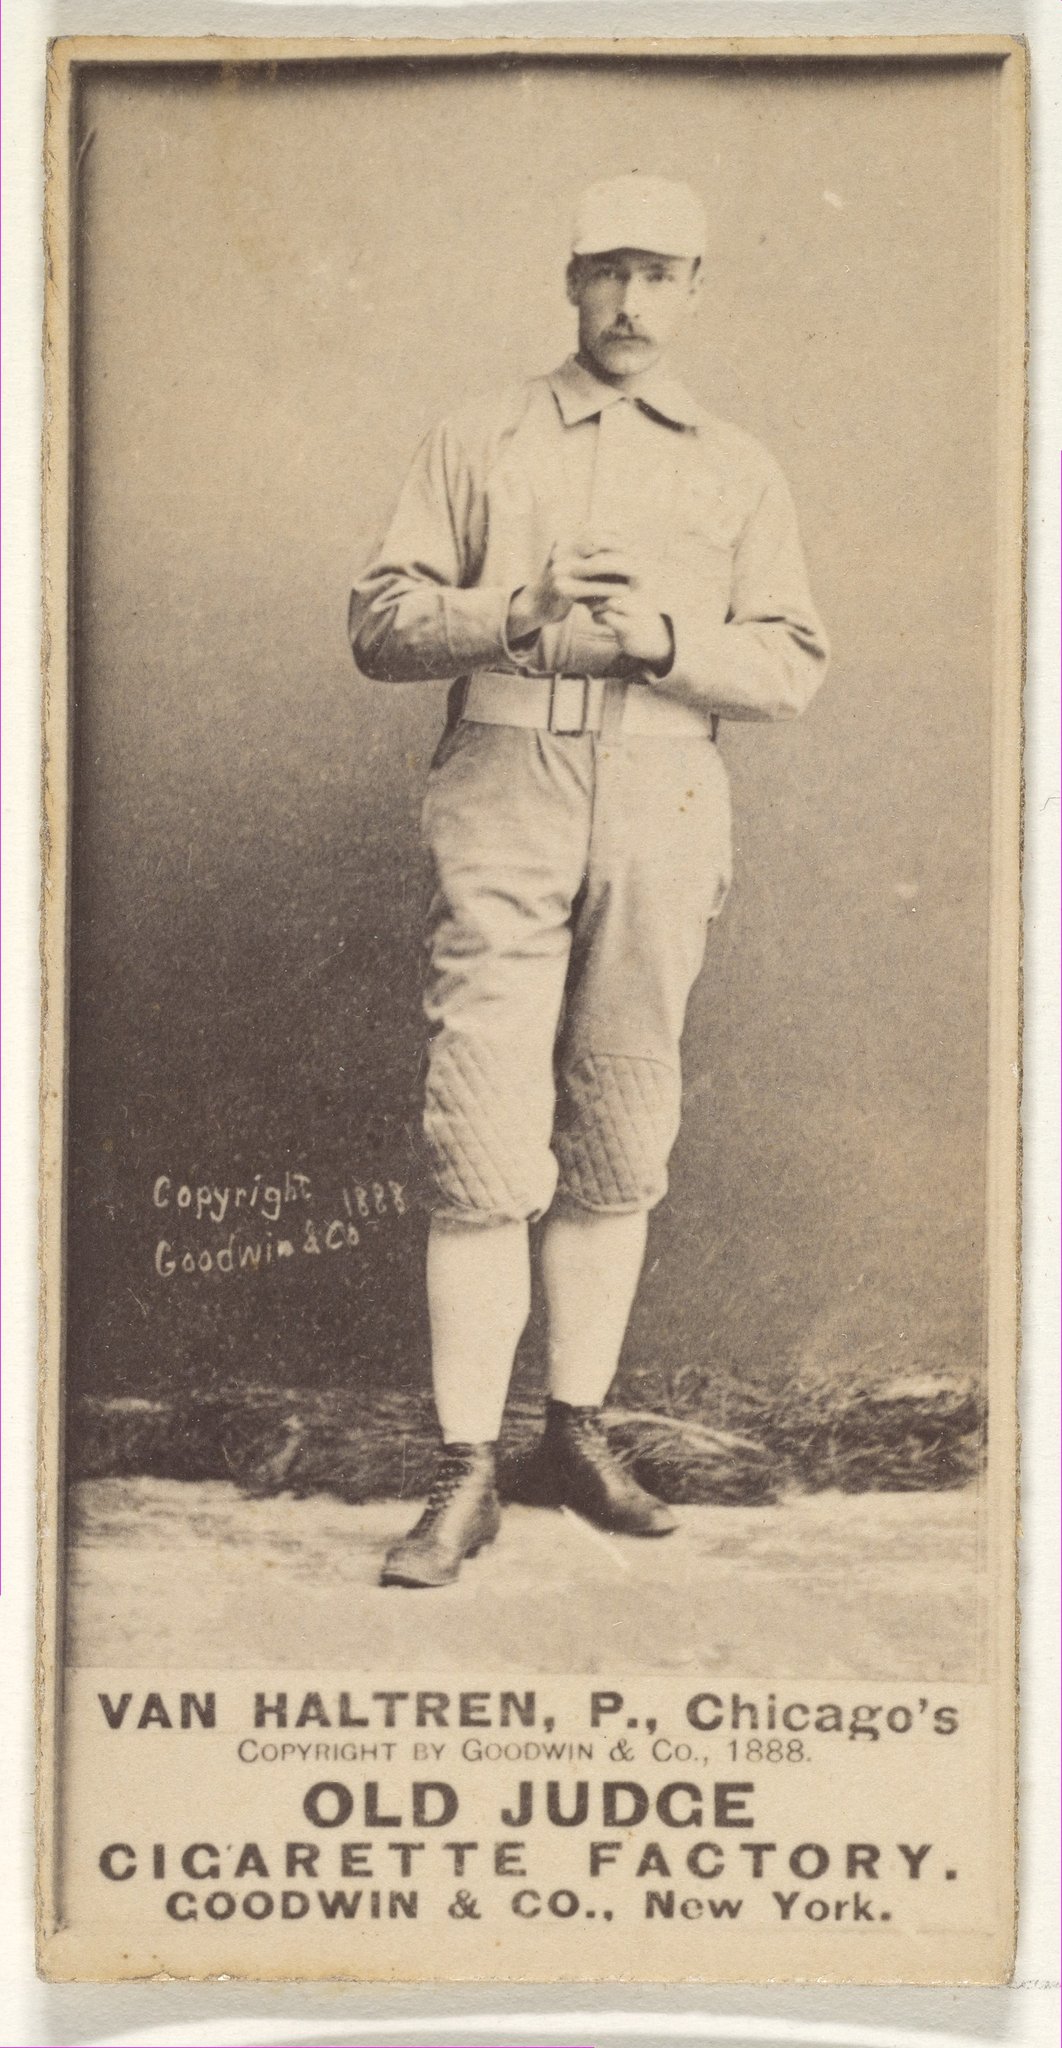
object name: baseball card, photograph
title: Van Haltren, Pitcher, Chicago, from the Old Judge series (N172) for Old Judge Cigarettes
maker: goodwin & company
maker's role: publisher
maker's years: 1850-1950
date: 1888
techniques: albumen silver print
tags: men,portraits,baseball,athletes